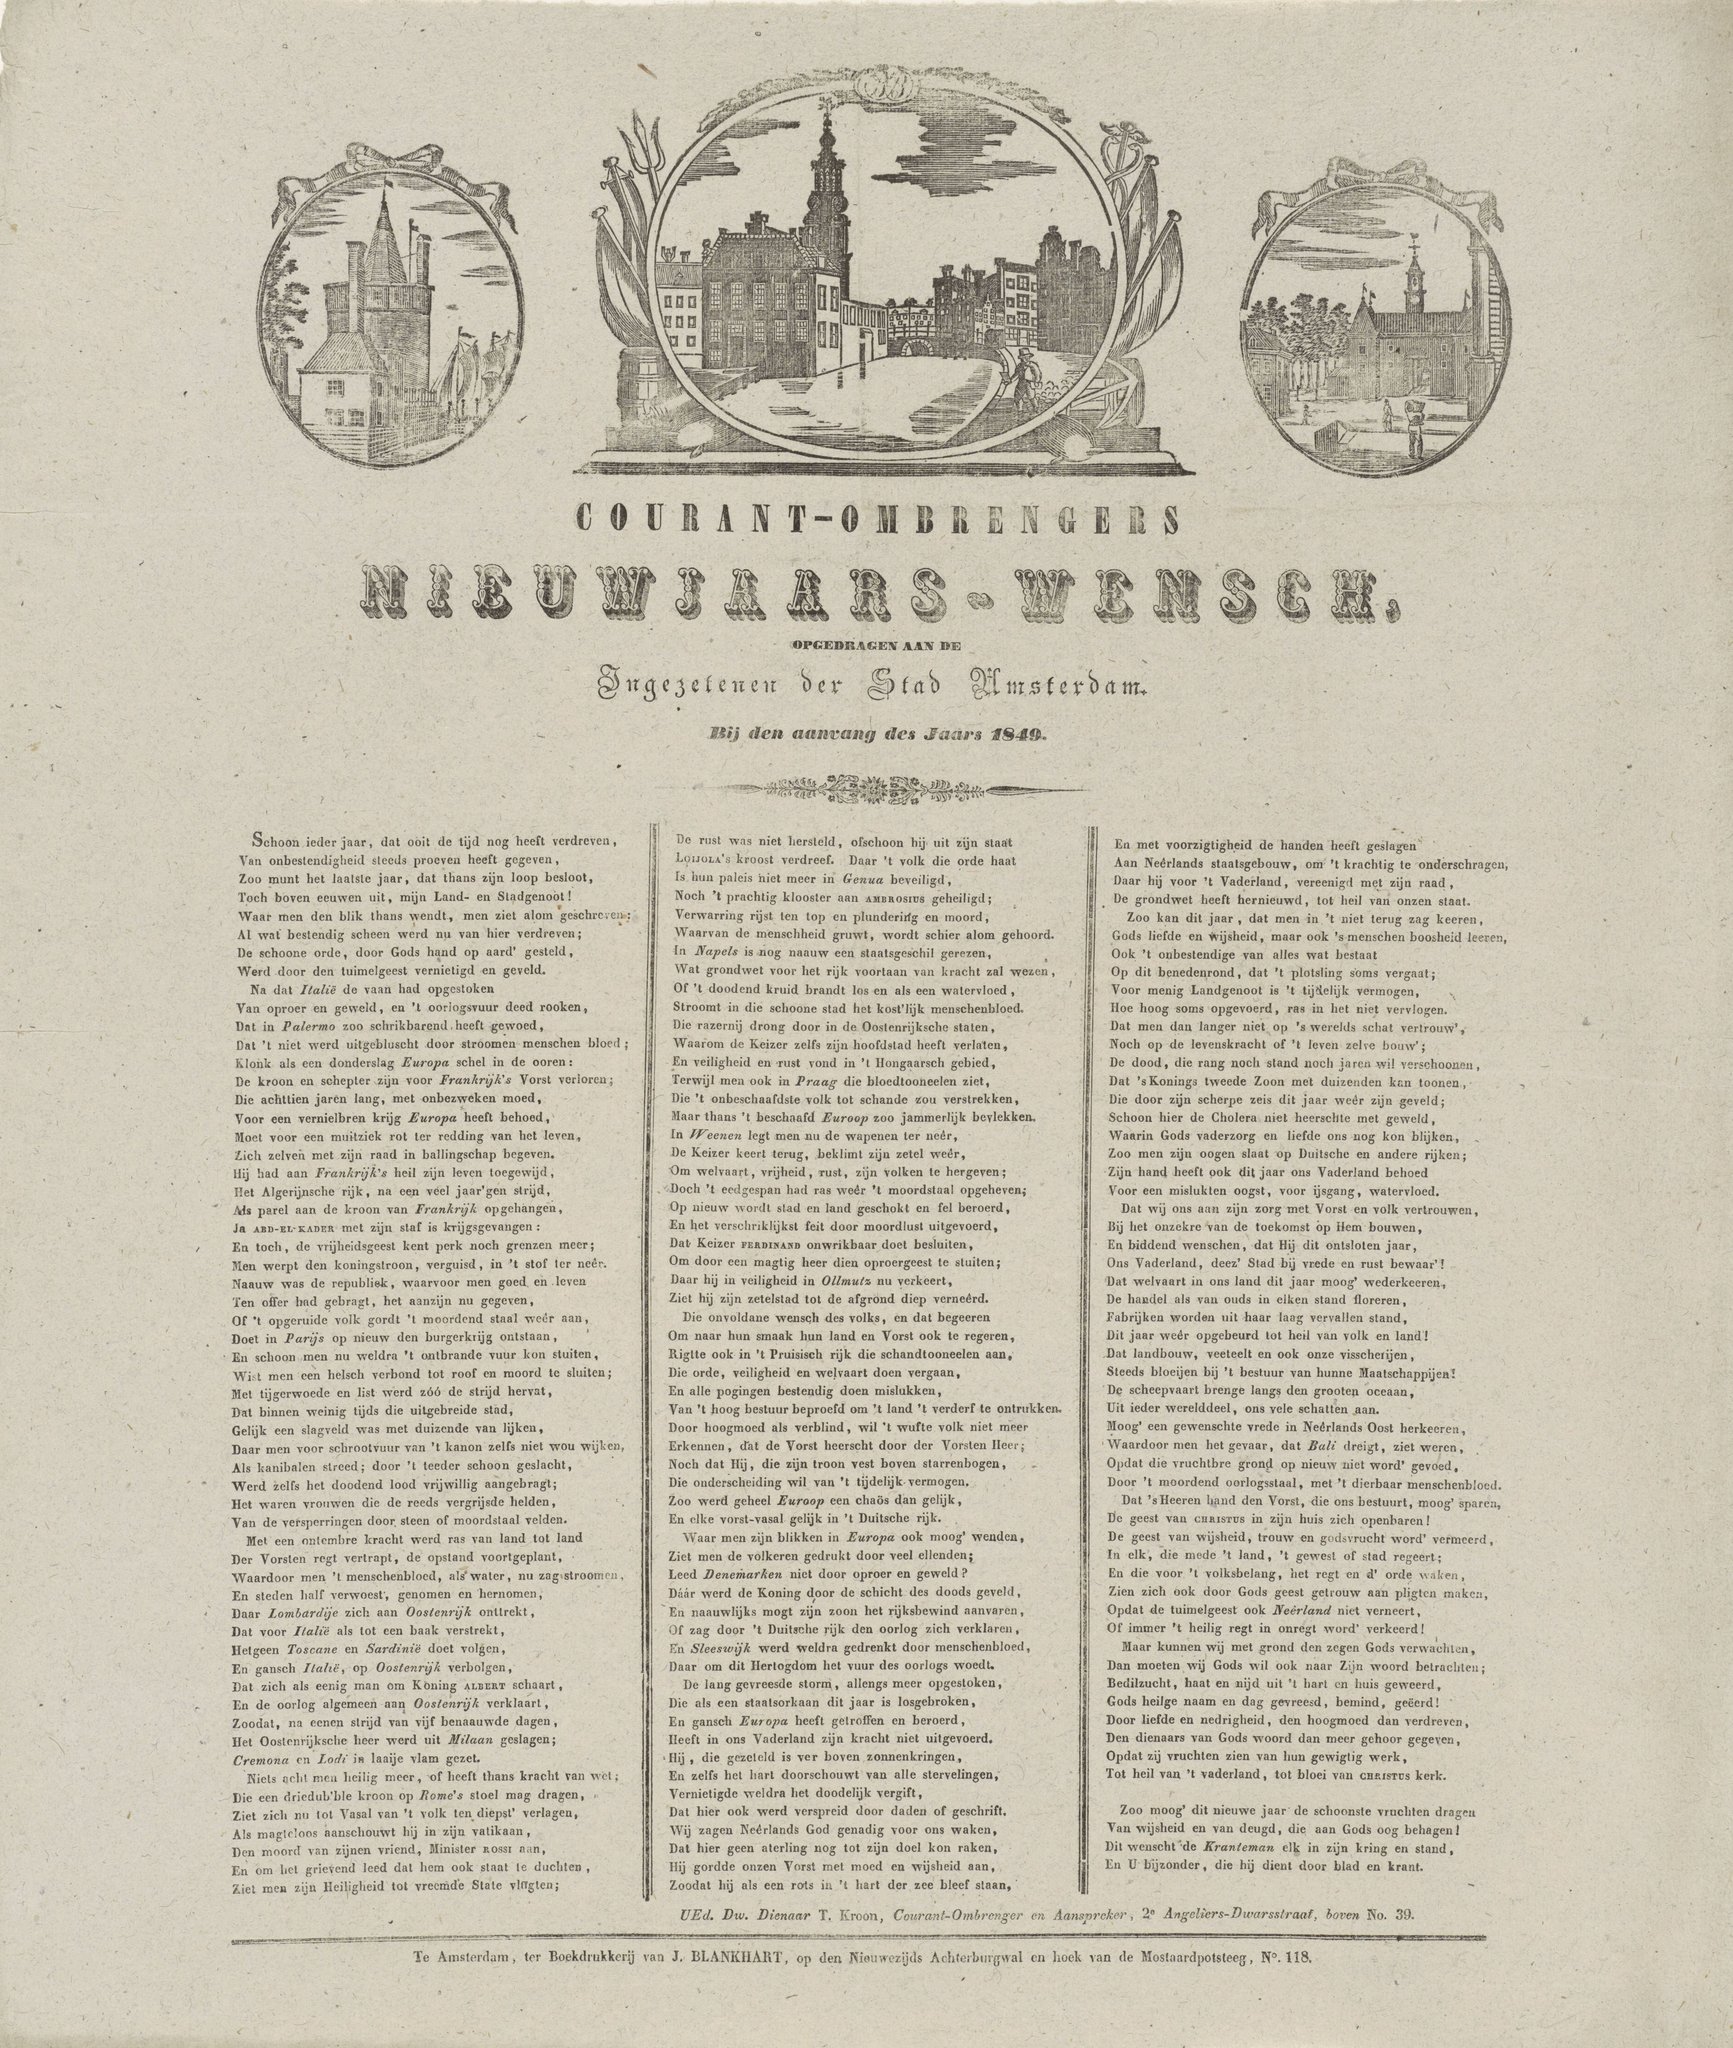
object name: new year card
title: Nieuwjaarswens van de Amsterdamse courantombrengers voor het jaar 1849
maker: Anonymous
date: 1848-1849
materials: paper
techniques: letterpress printing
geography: amsterdam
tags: delivery (of newspaper), street, amsterdam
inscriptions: collector's mark: Lugt 2228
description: Nieuwjaarswens namens de ombrengers van couranten (krantenbezorgers) te Amsterdam voor het jaar 1849. Bovenaan drie medaillons met centraal een gezicht op het Singel bij de Munt met op de kade een krantenbezorger, links de Schreierstoren, rechts de Leidsepoort. Onderaan een gedicht in drie kolommen. Van de courantombrenger: T. Kroon.